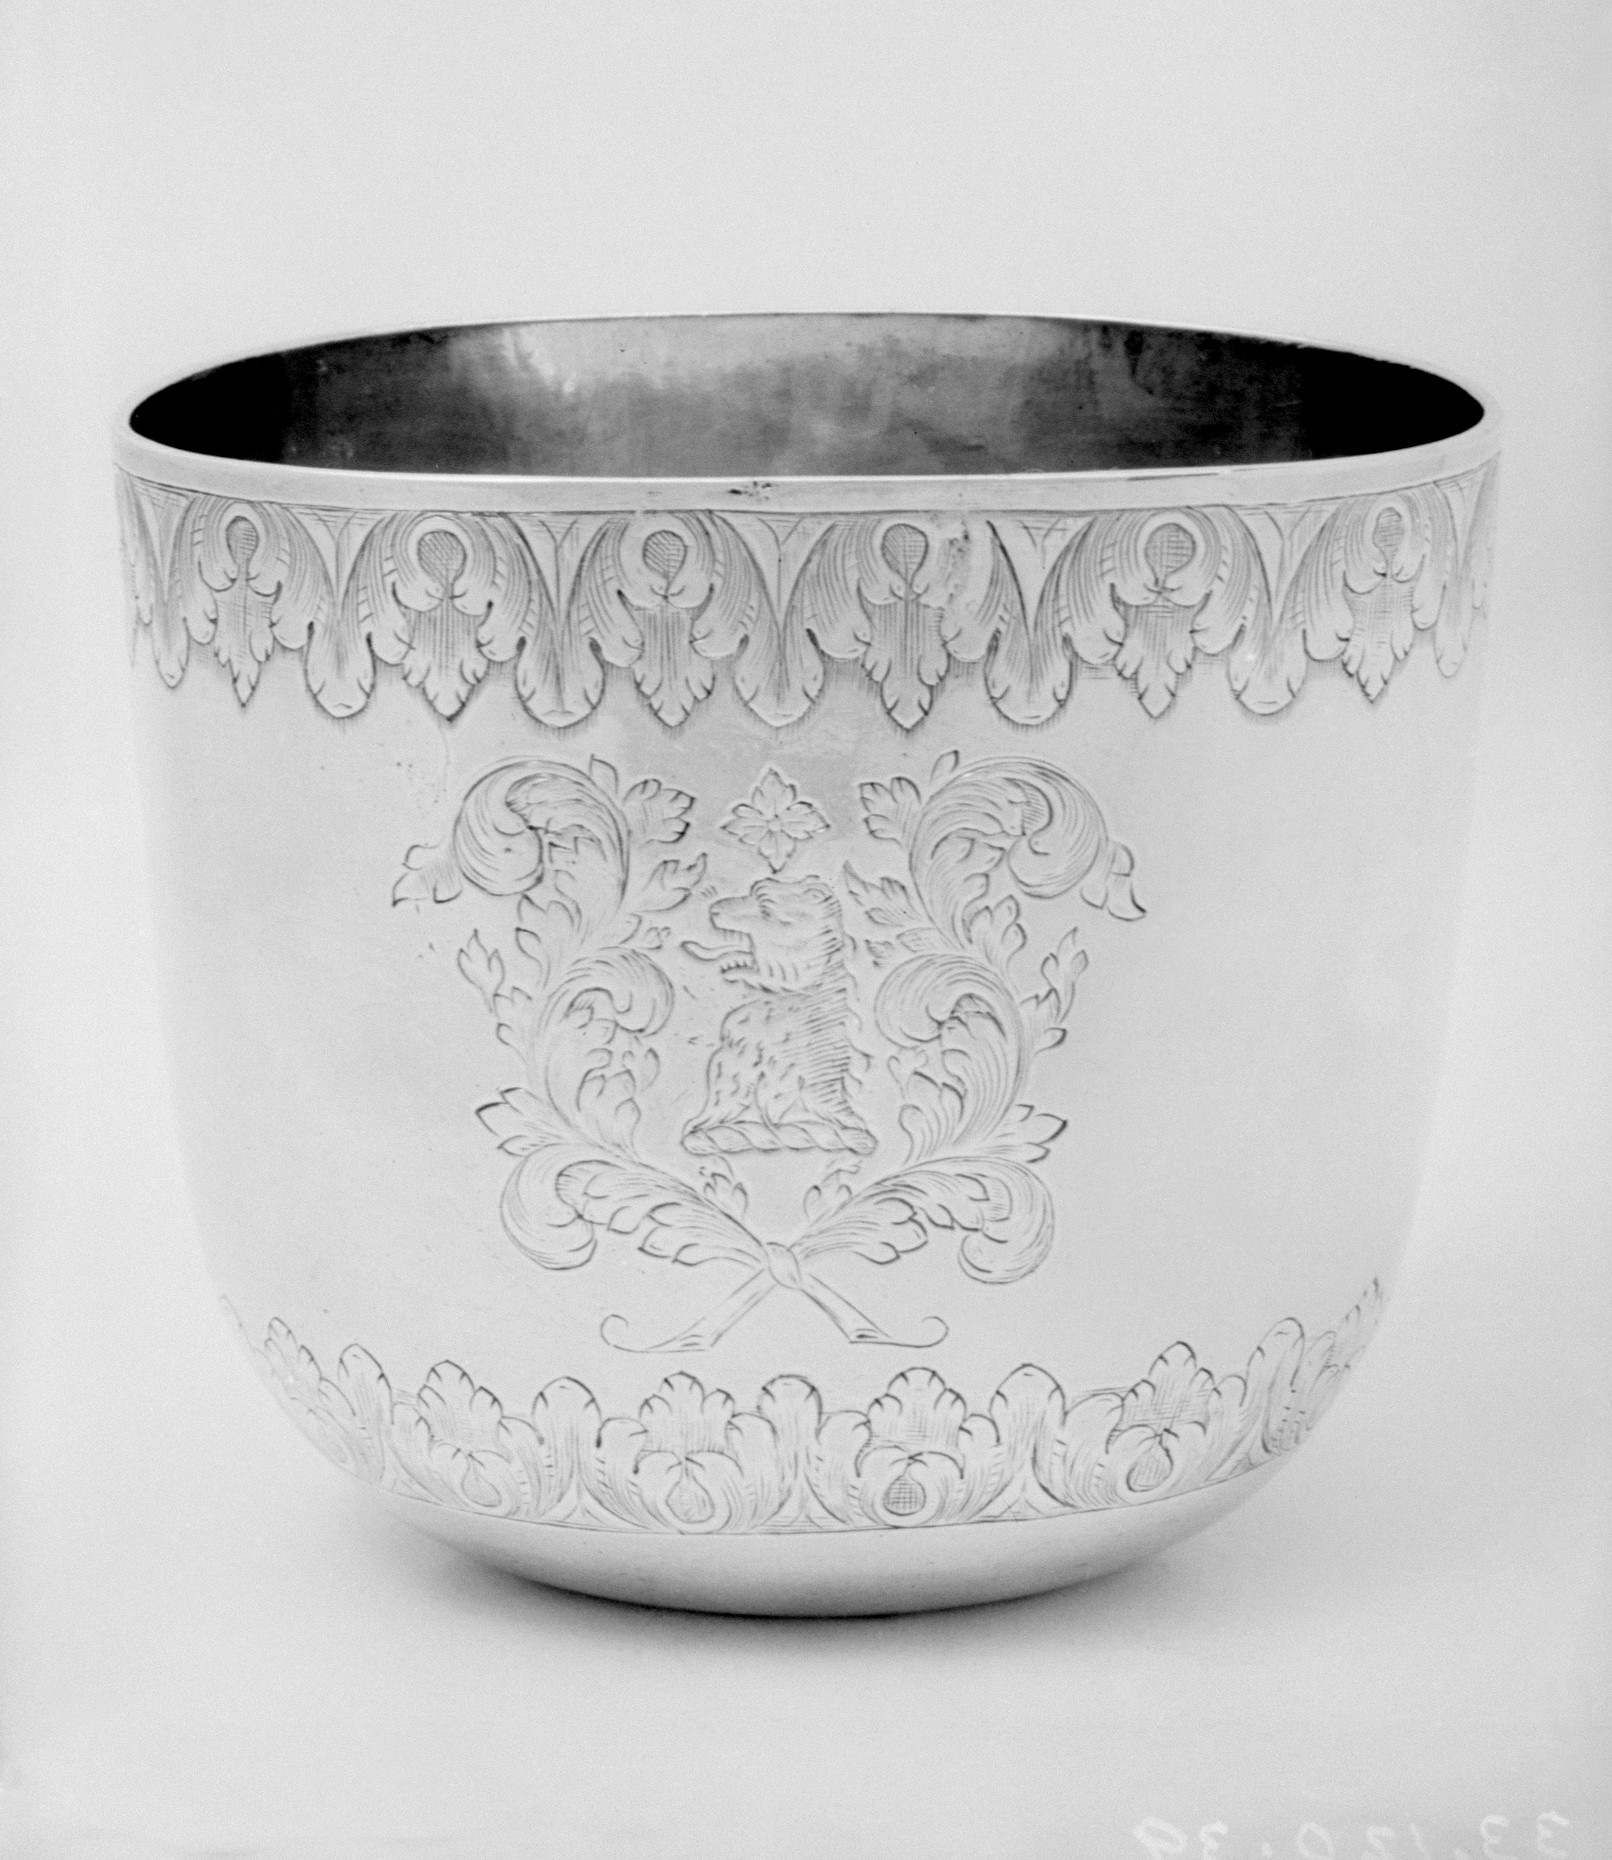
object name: cup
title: Cup (probably part of a traveling set)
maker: t. t., england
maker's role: maker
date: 1680-1690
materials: silver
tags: lions